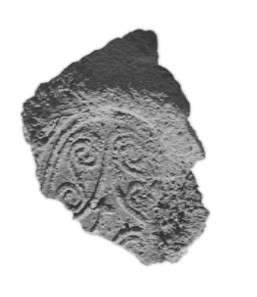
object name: sealing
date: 2030-1640 BCE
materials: clay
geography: egypt